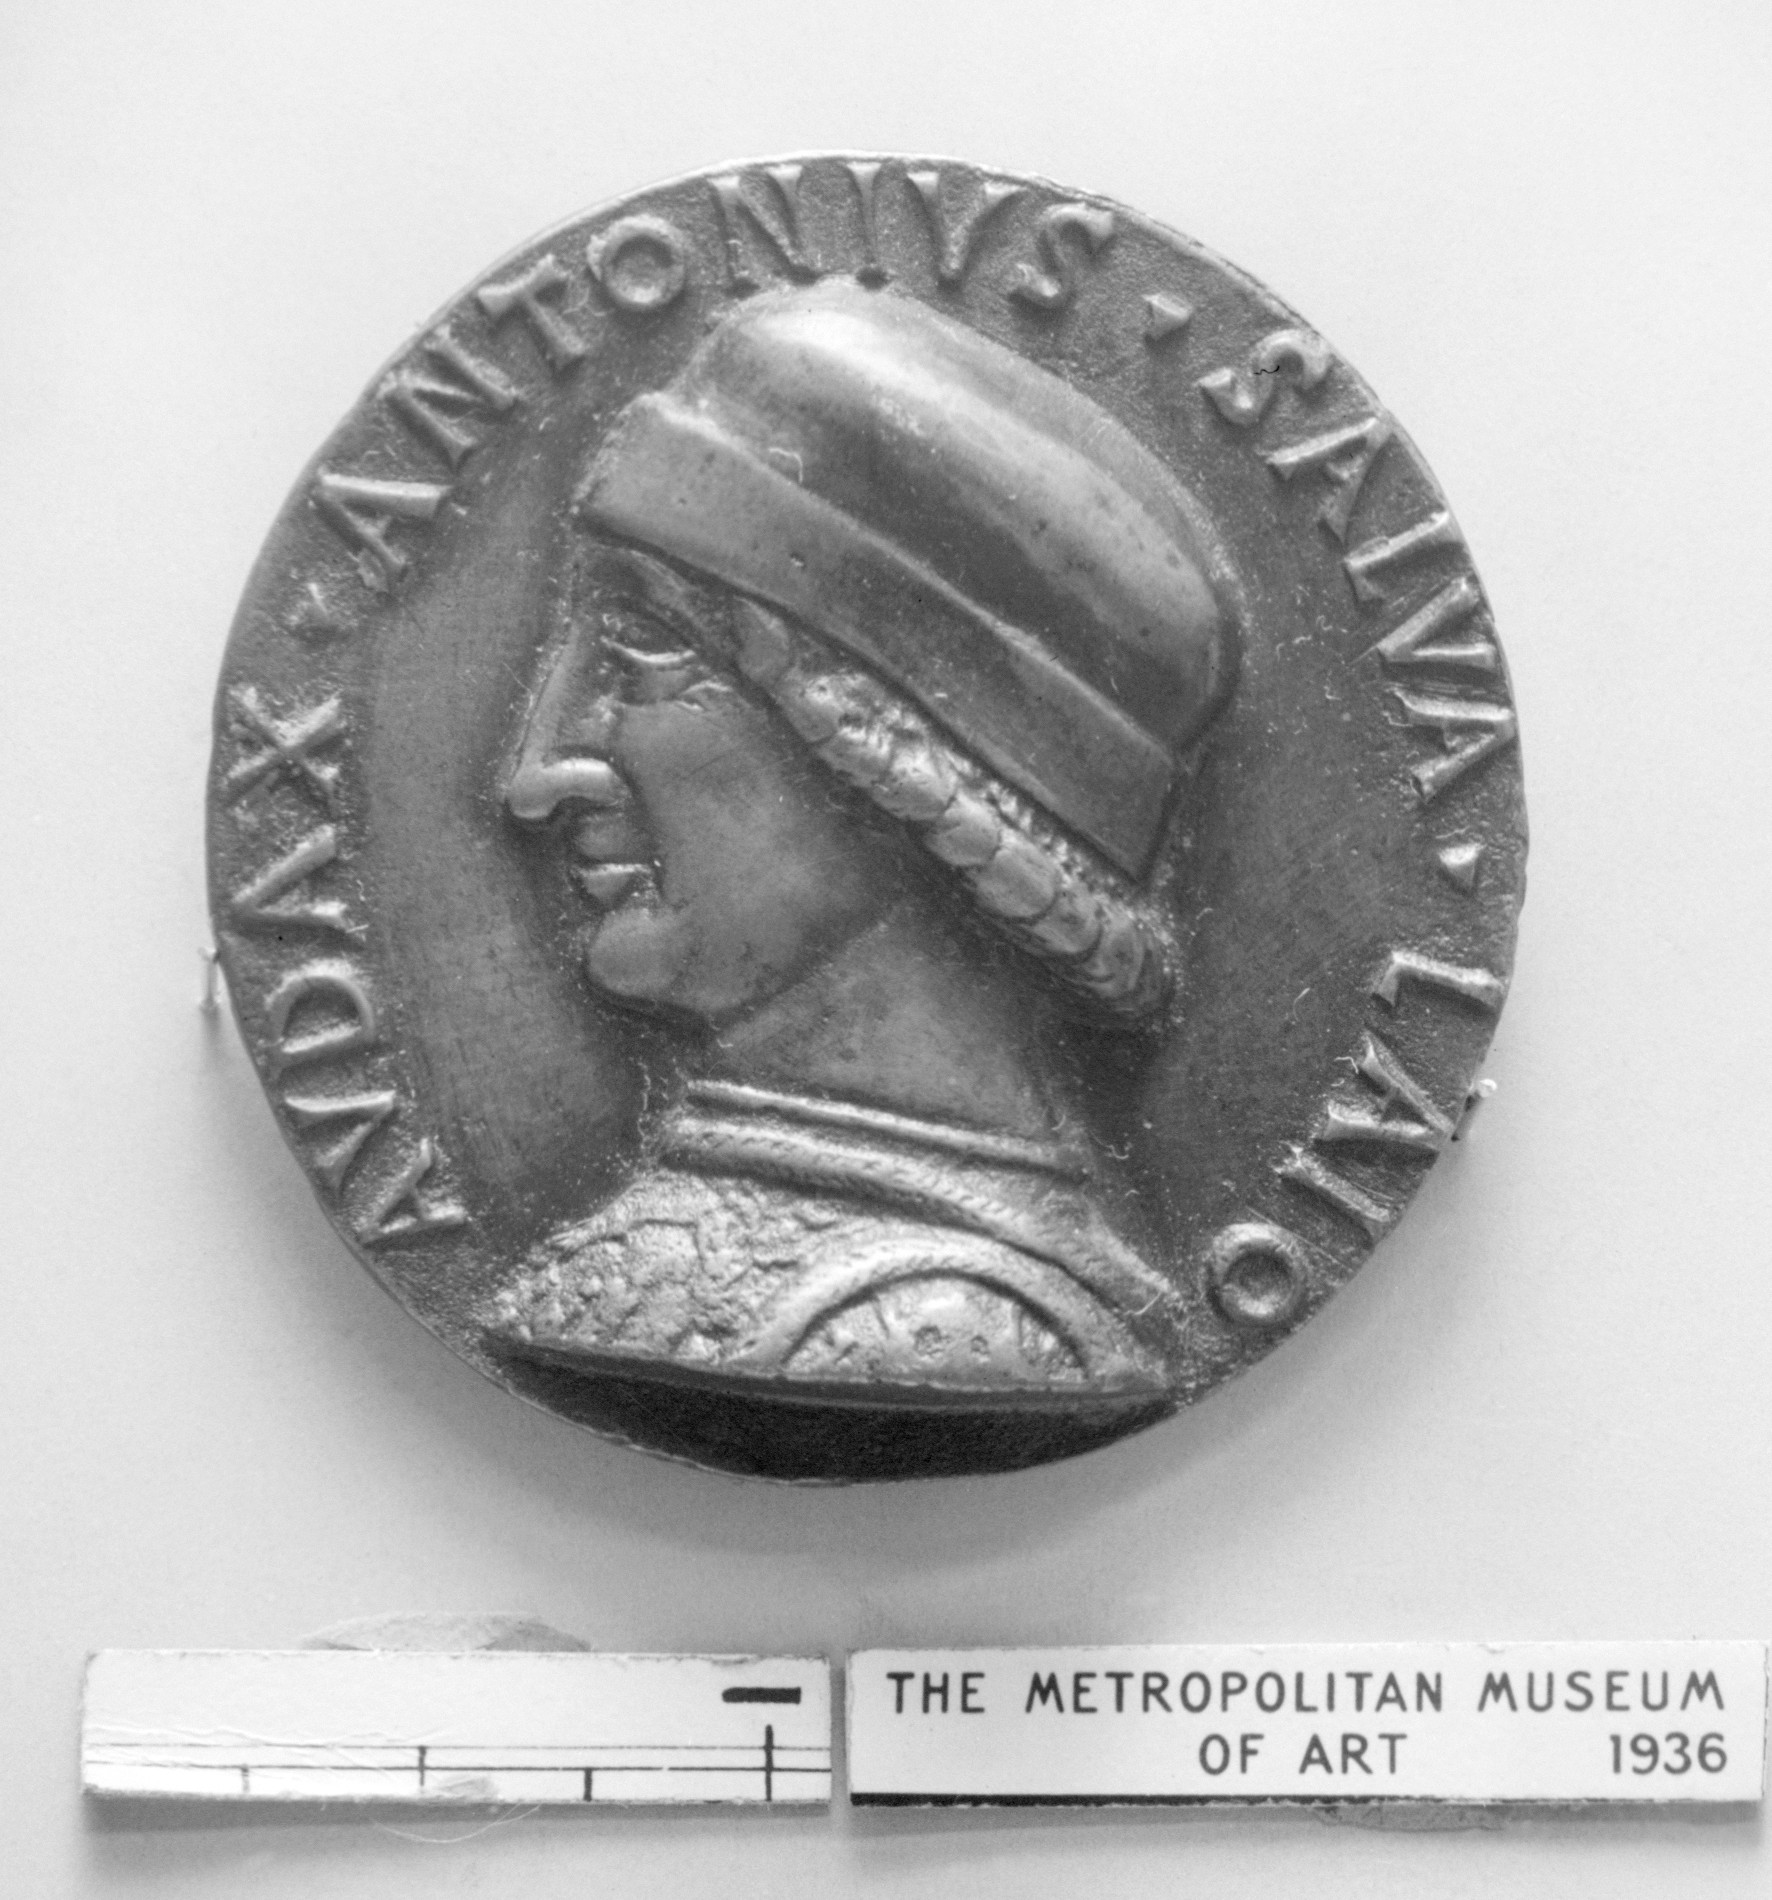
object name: medal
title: Antonio Salvalaio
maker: petrecino of florence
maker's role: artist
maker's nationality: italian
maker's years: 1450-1499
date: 1460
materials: bronze, patina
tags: men,profiles